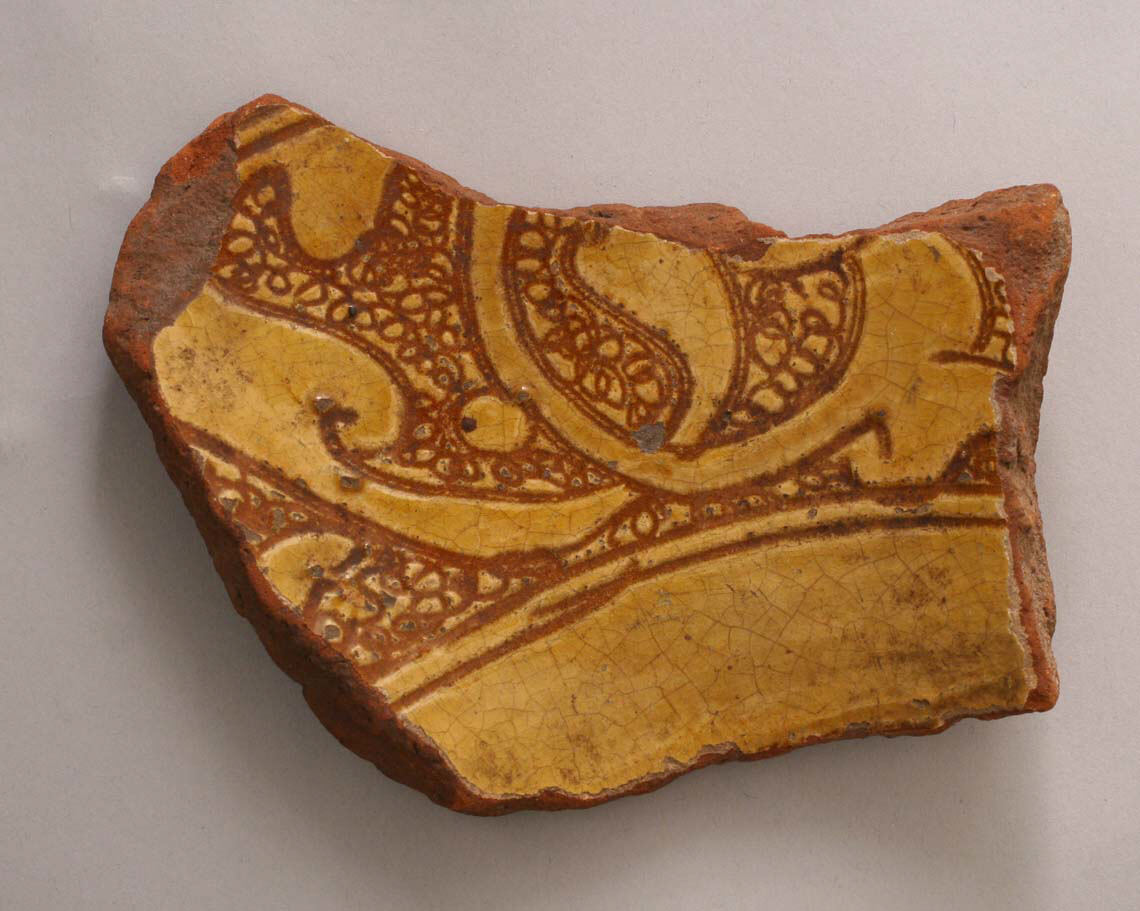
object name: ceramic fragment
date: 1301-1500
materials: earthenware, glaze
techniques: coloring, incising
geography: egypt